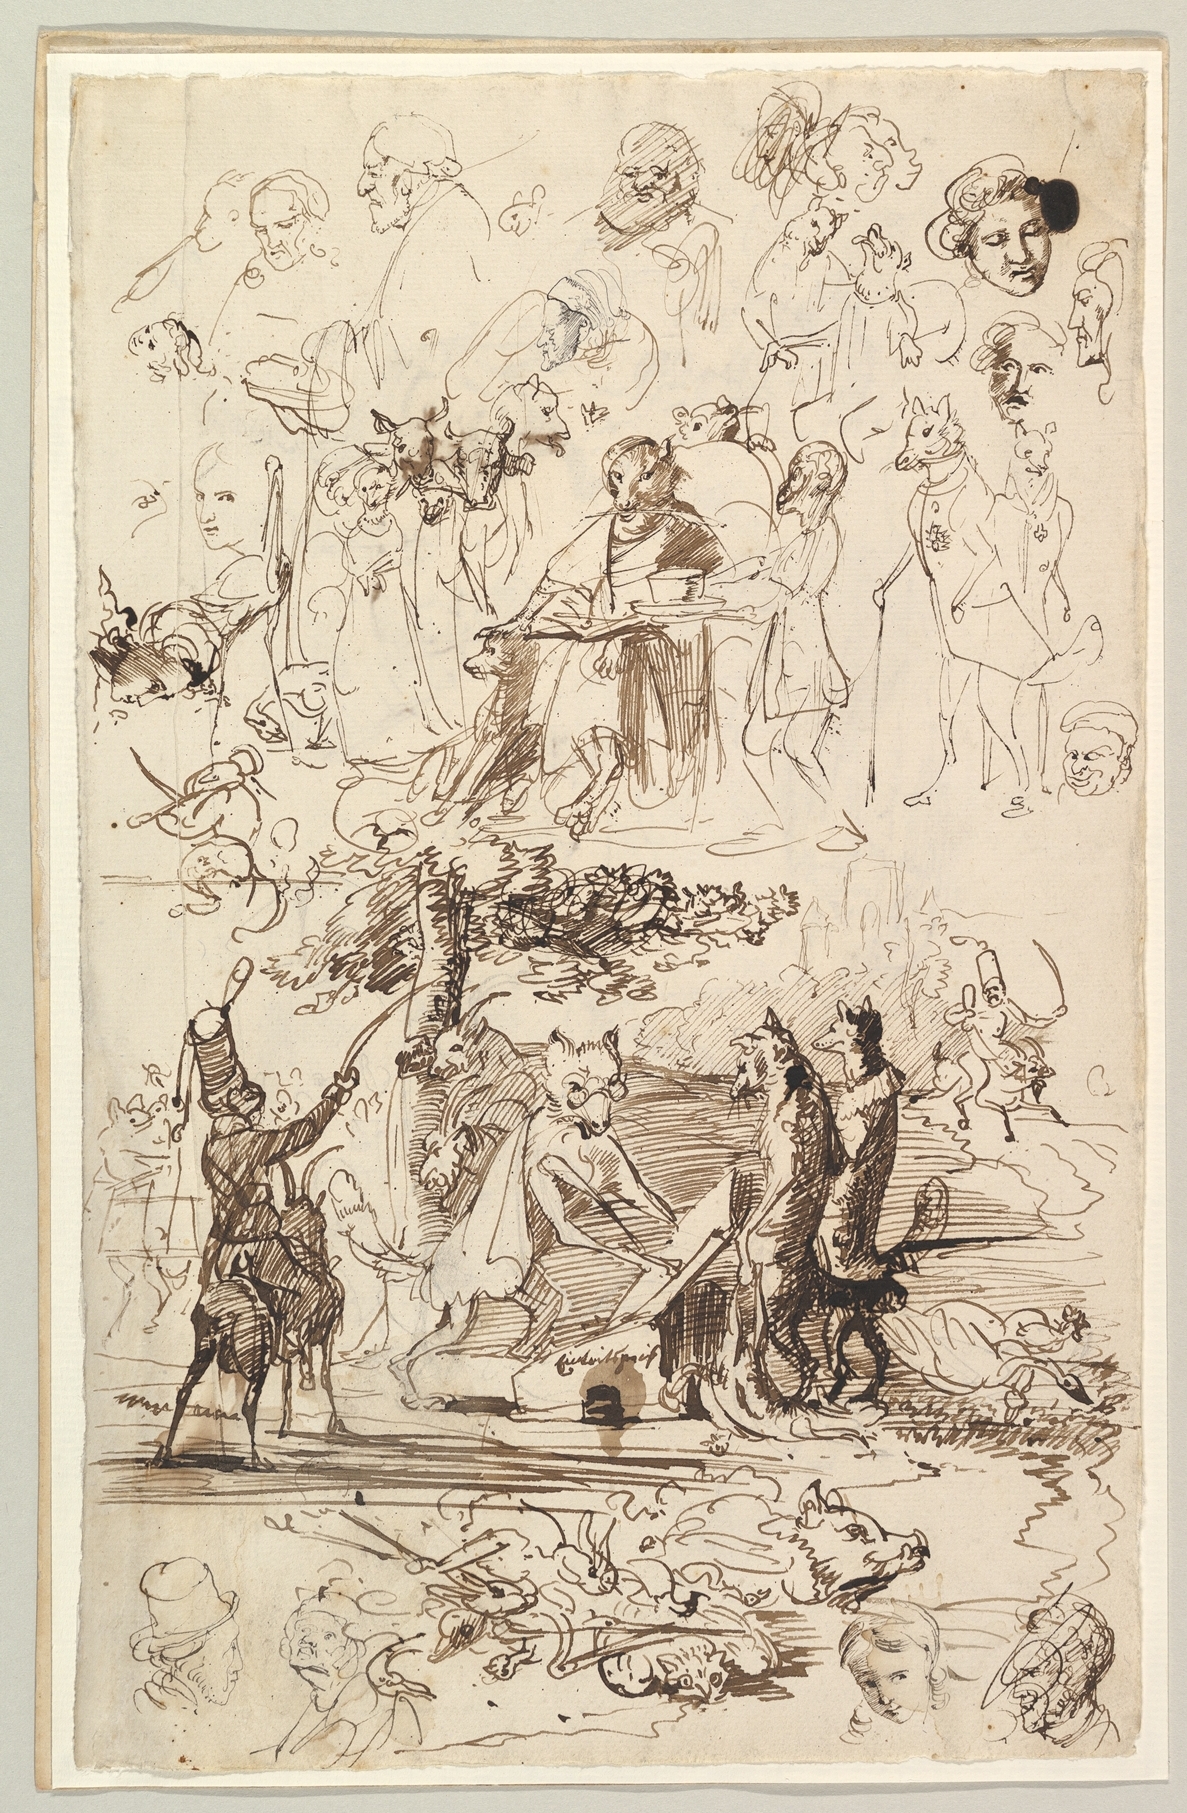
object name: drawing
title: Sheet of Studies, Including for Reineke Fuchs; verso: Studies of Soldiers and of a Battle in a Wood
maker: wilhelm von kaulbach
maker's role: artist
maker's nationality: german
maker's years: 1804-1874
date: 1834-1866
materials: ink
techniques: pen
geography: germany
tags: soldiers,faces,horses